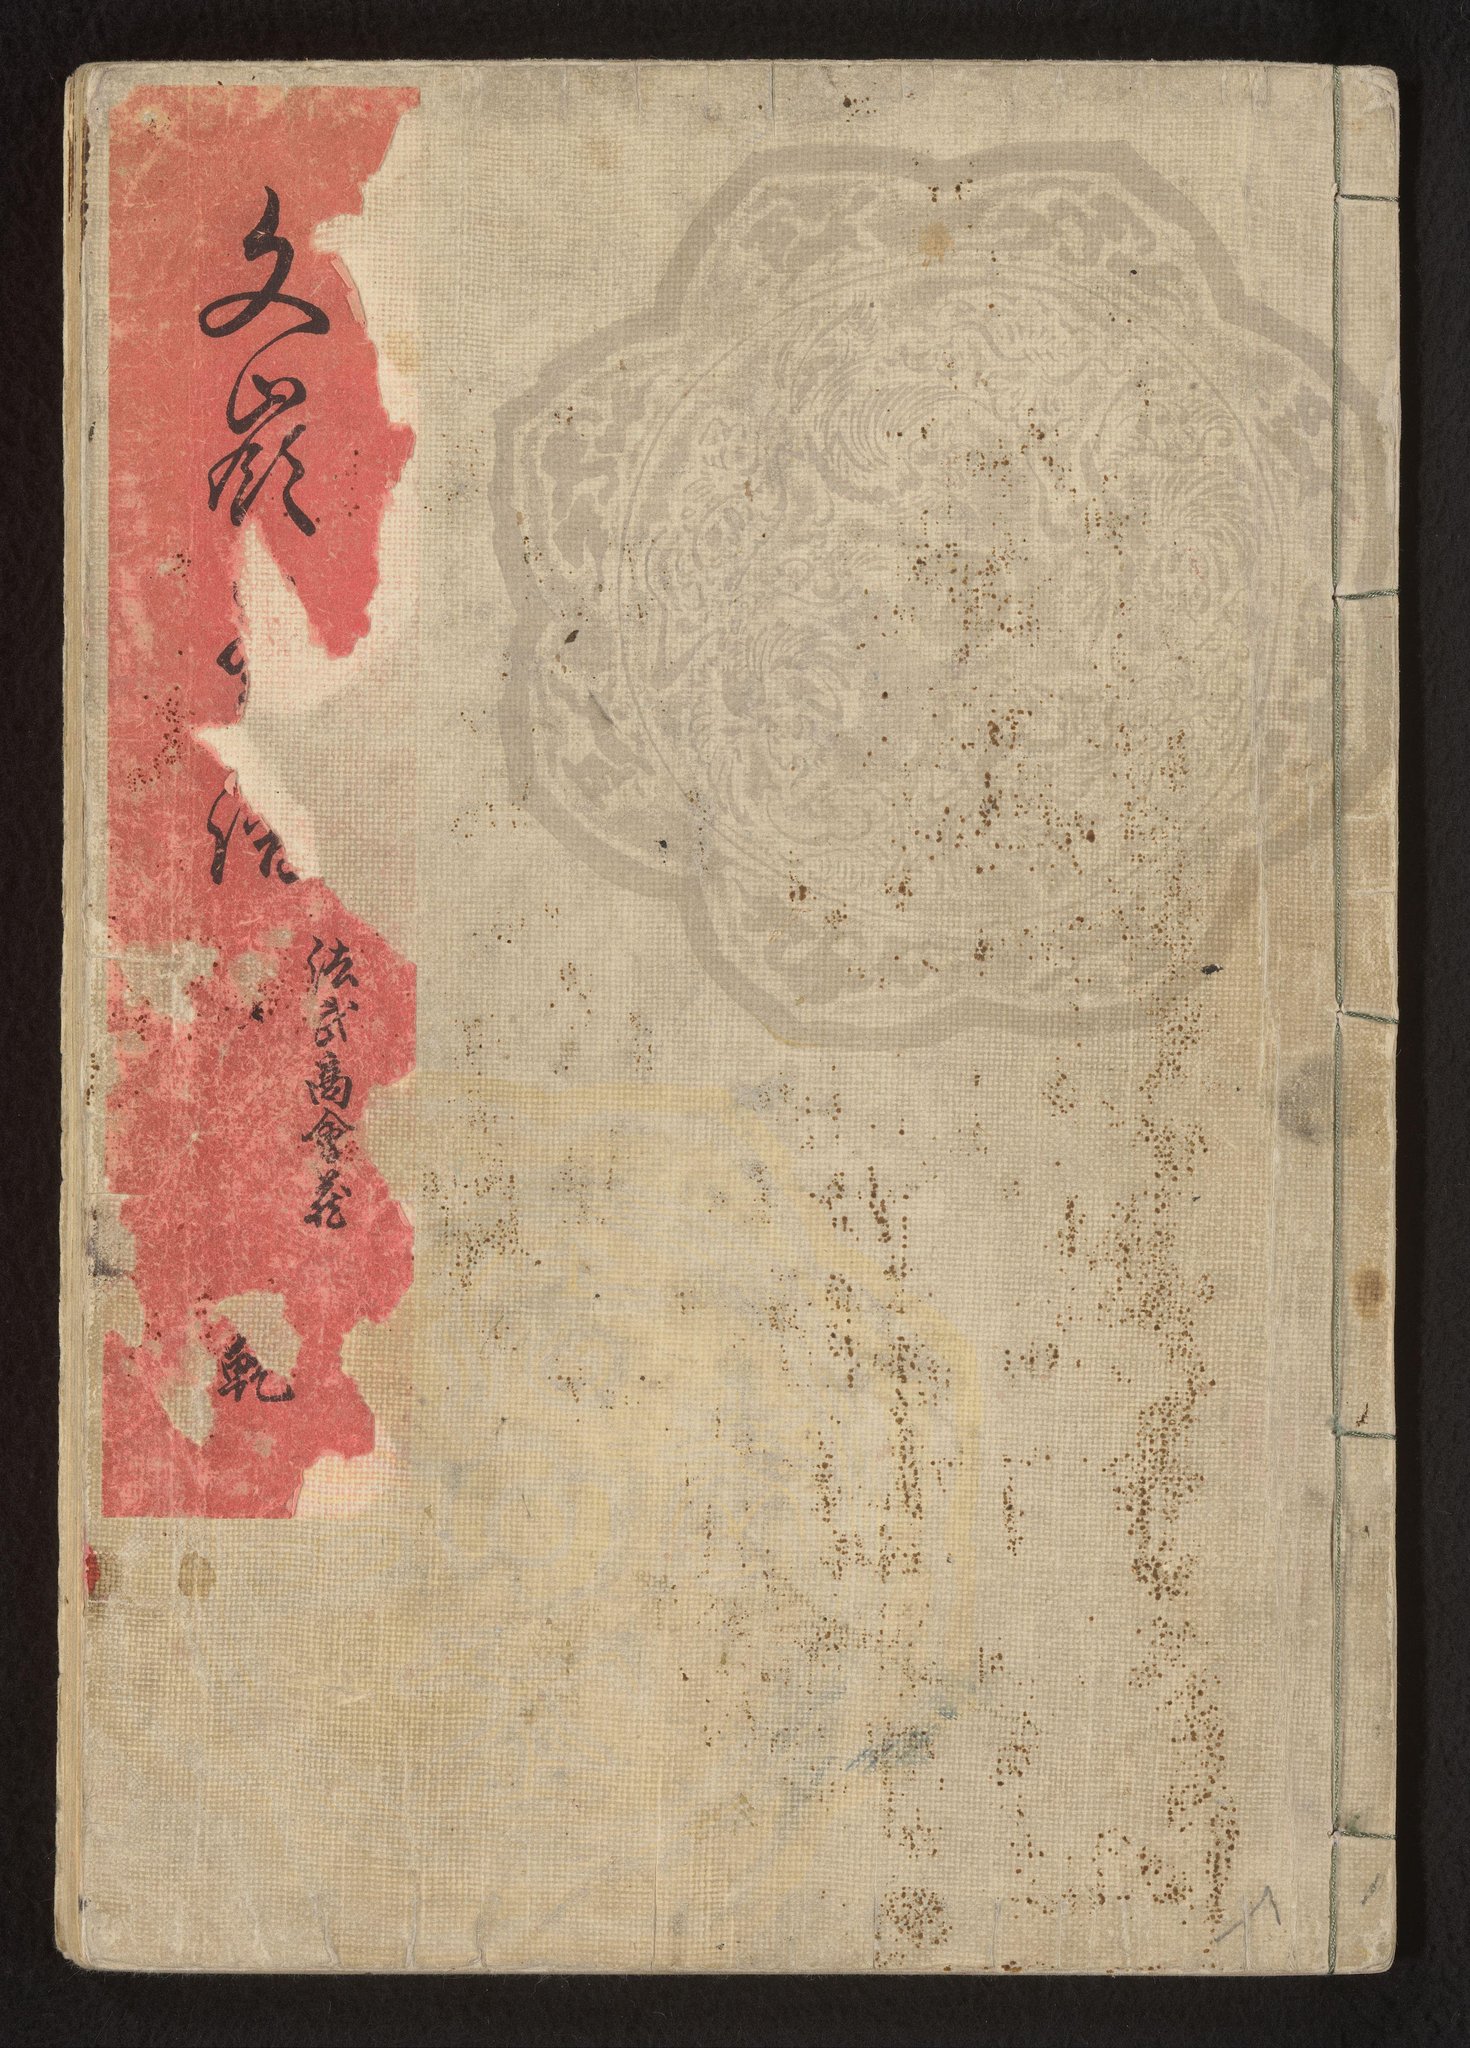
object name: book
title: Bunrei gafu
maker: maekawa bunrei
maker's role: print maker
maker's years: 1837-1917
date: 1885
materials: paper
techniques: woodcut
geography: yokohama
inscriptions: collector's mark: ‘Rijksschool voor kunstnijverheid’ Lugt 3937, collector's mark: Lugt 2228